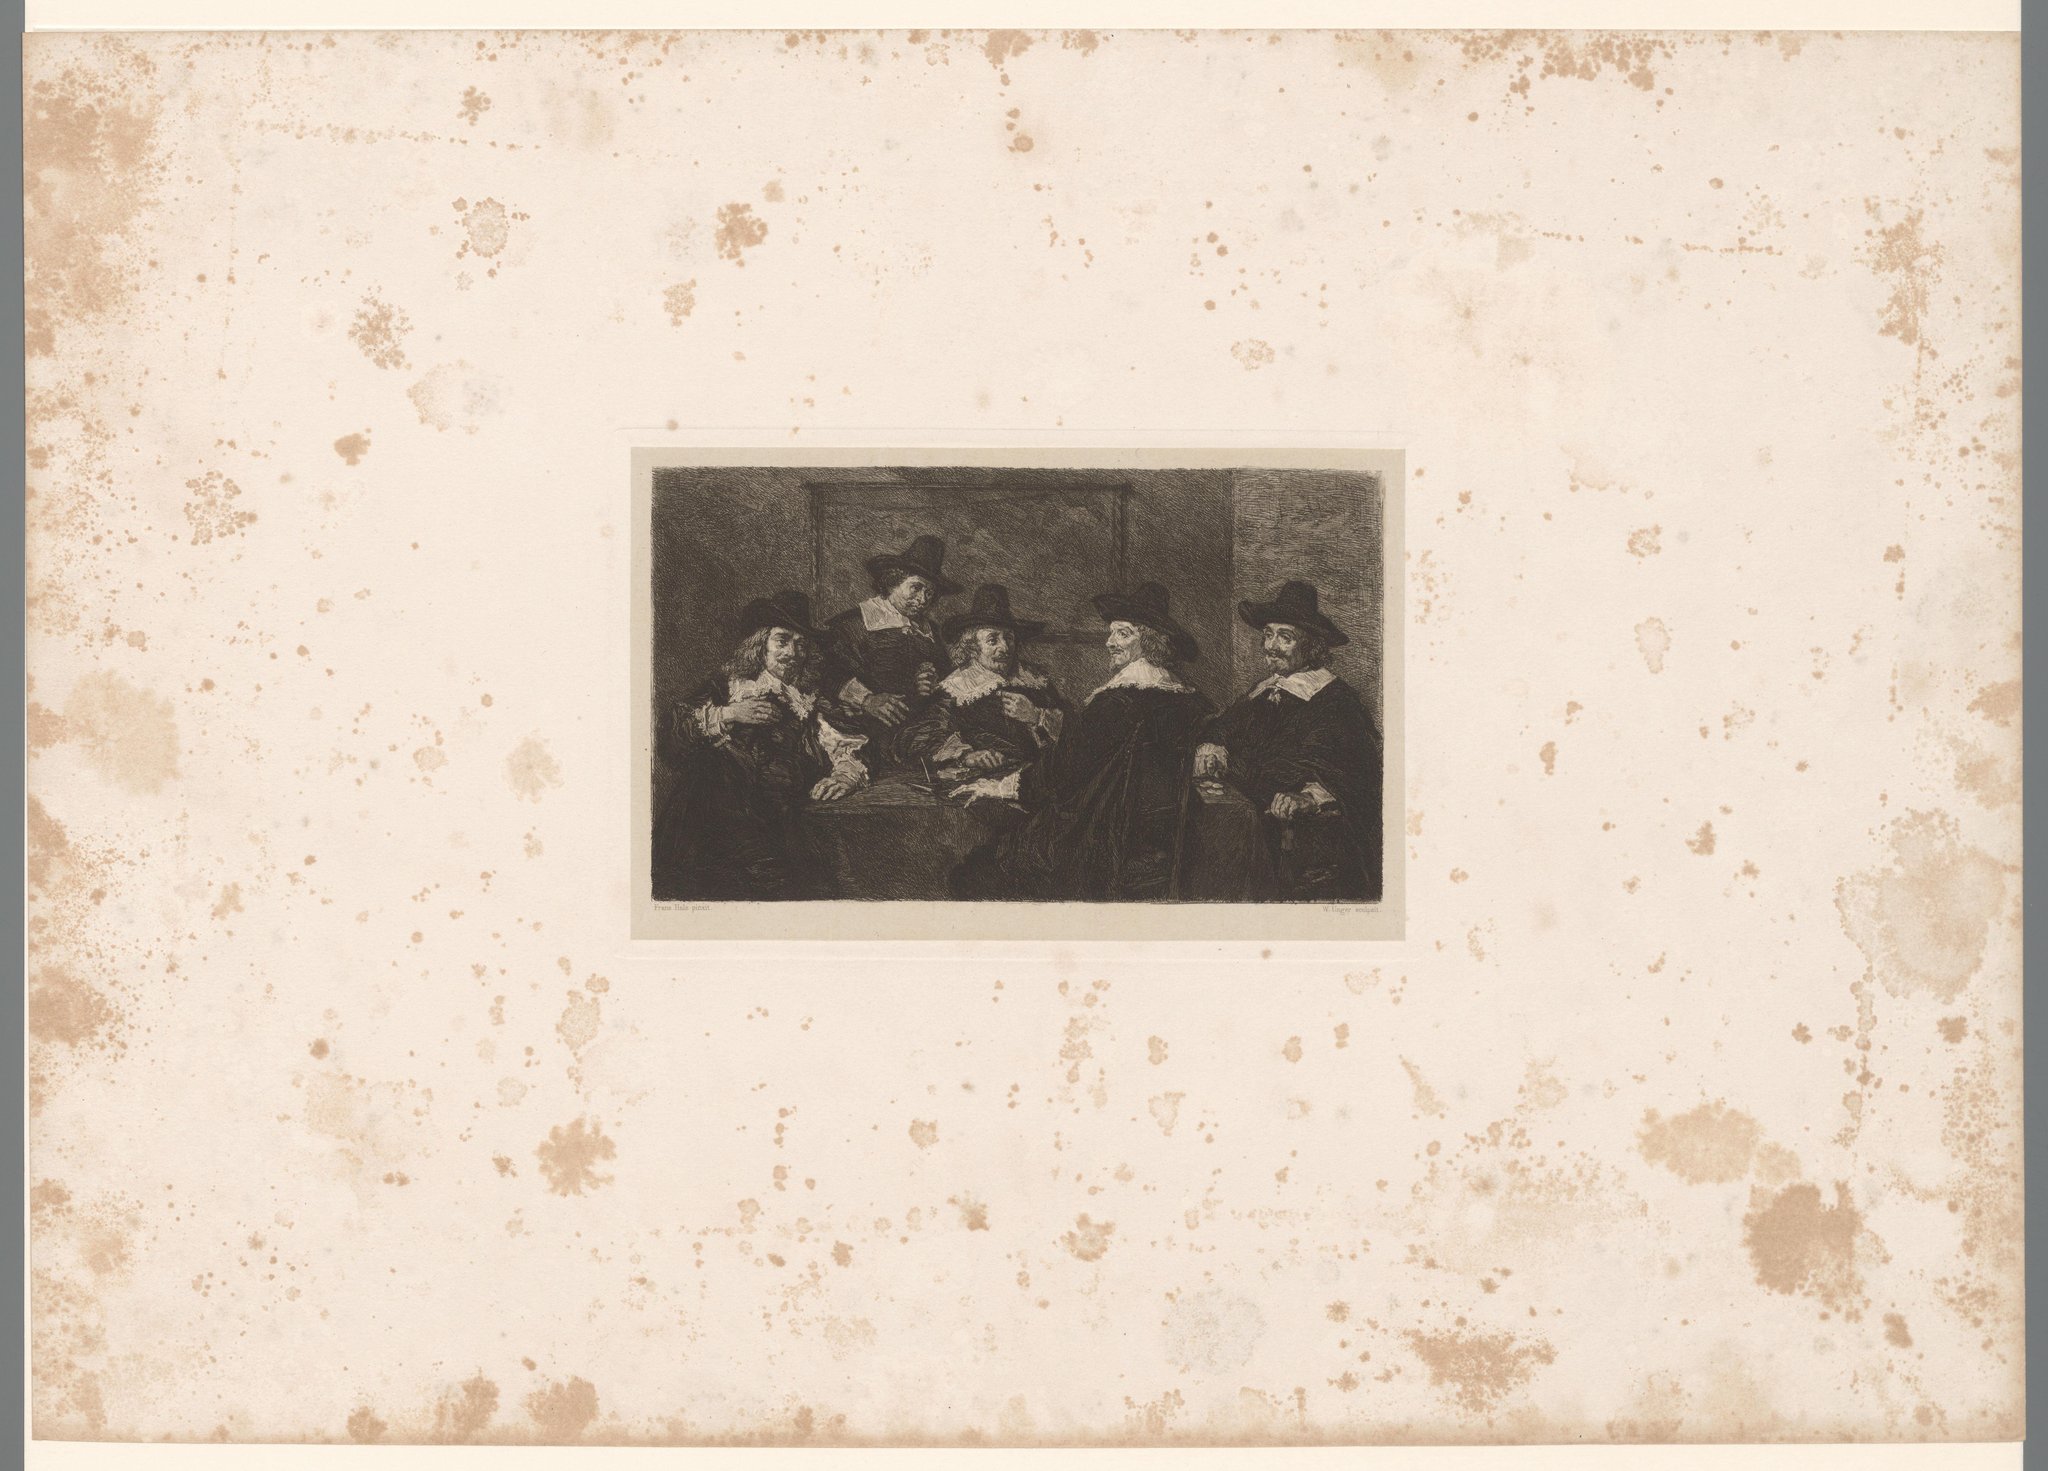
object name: print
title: Regenten van het Haarlemse Sint Elisabeths Gasthuis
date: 1847-1889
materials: paper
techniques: etching, intaglio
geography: haarlem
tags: haarlem, maps, atlases, historical persons, board, esp. governors, trustees, etc. (dutch: 'regenten') - aa - women (dutch: 'regentessen')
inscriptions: collector's mark: Lugt 2228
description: Prent naar het schilderij door Frans Hals in het Frans Halsmuseum te Haarlem (inv.nr. os I-114).